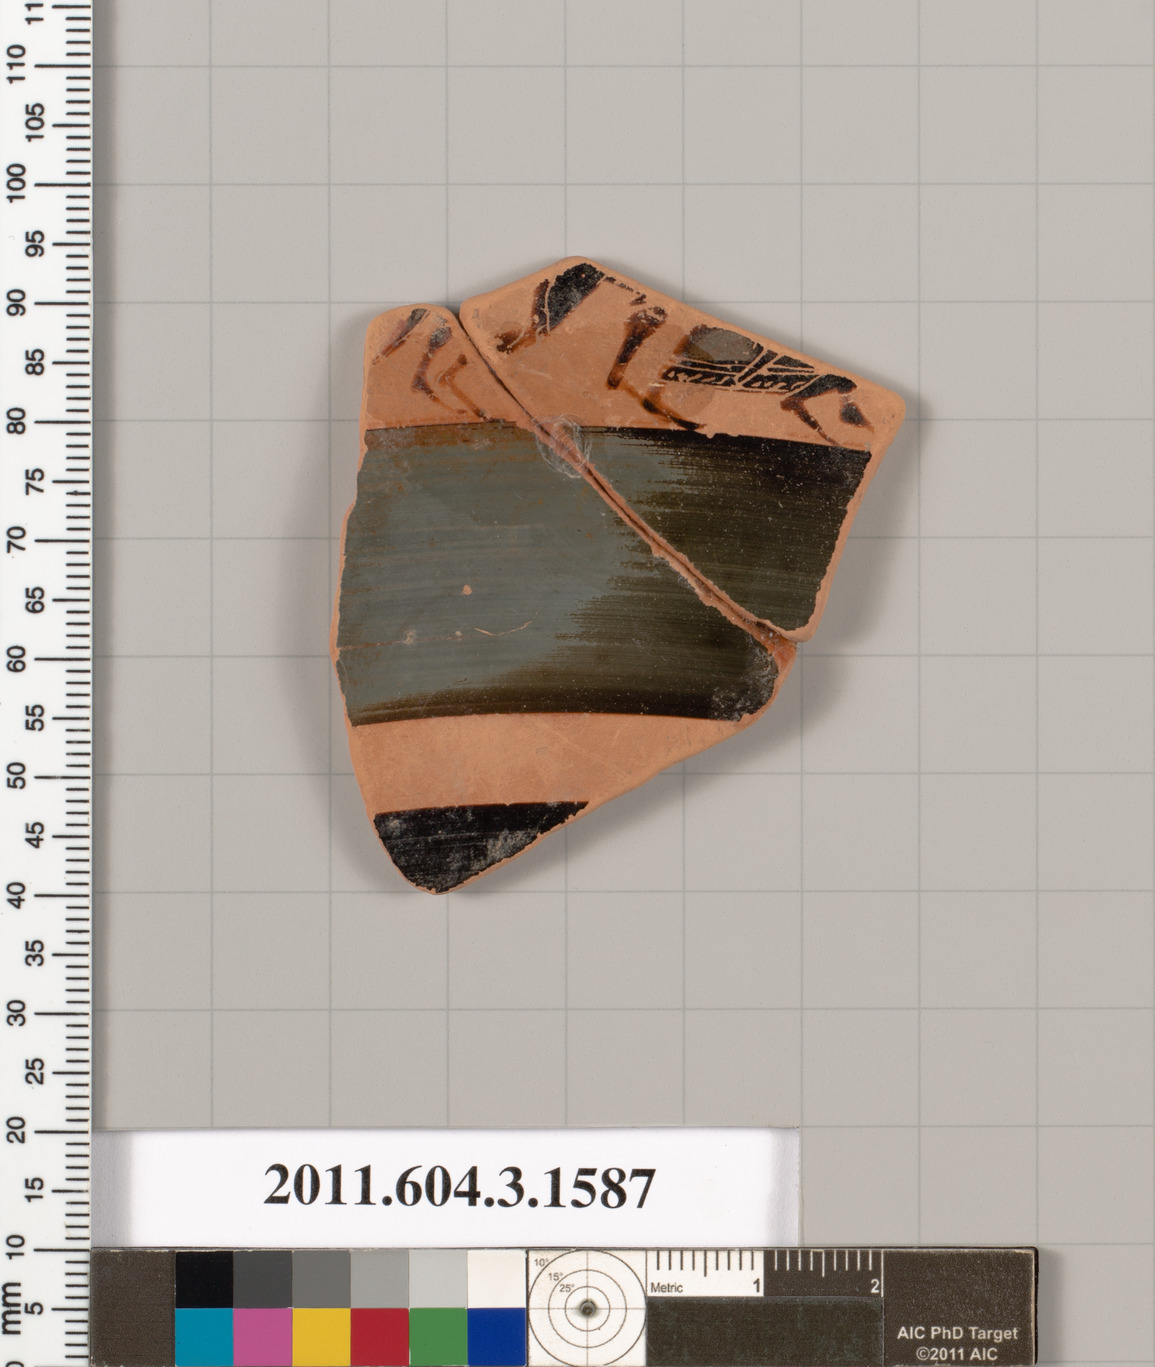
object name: kylix fragment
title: Terracotta fragment of a kylix: Band cup (drinking cup)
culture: greek, attic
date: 567-535 BCE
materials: terracotta